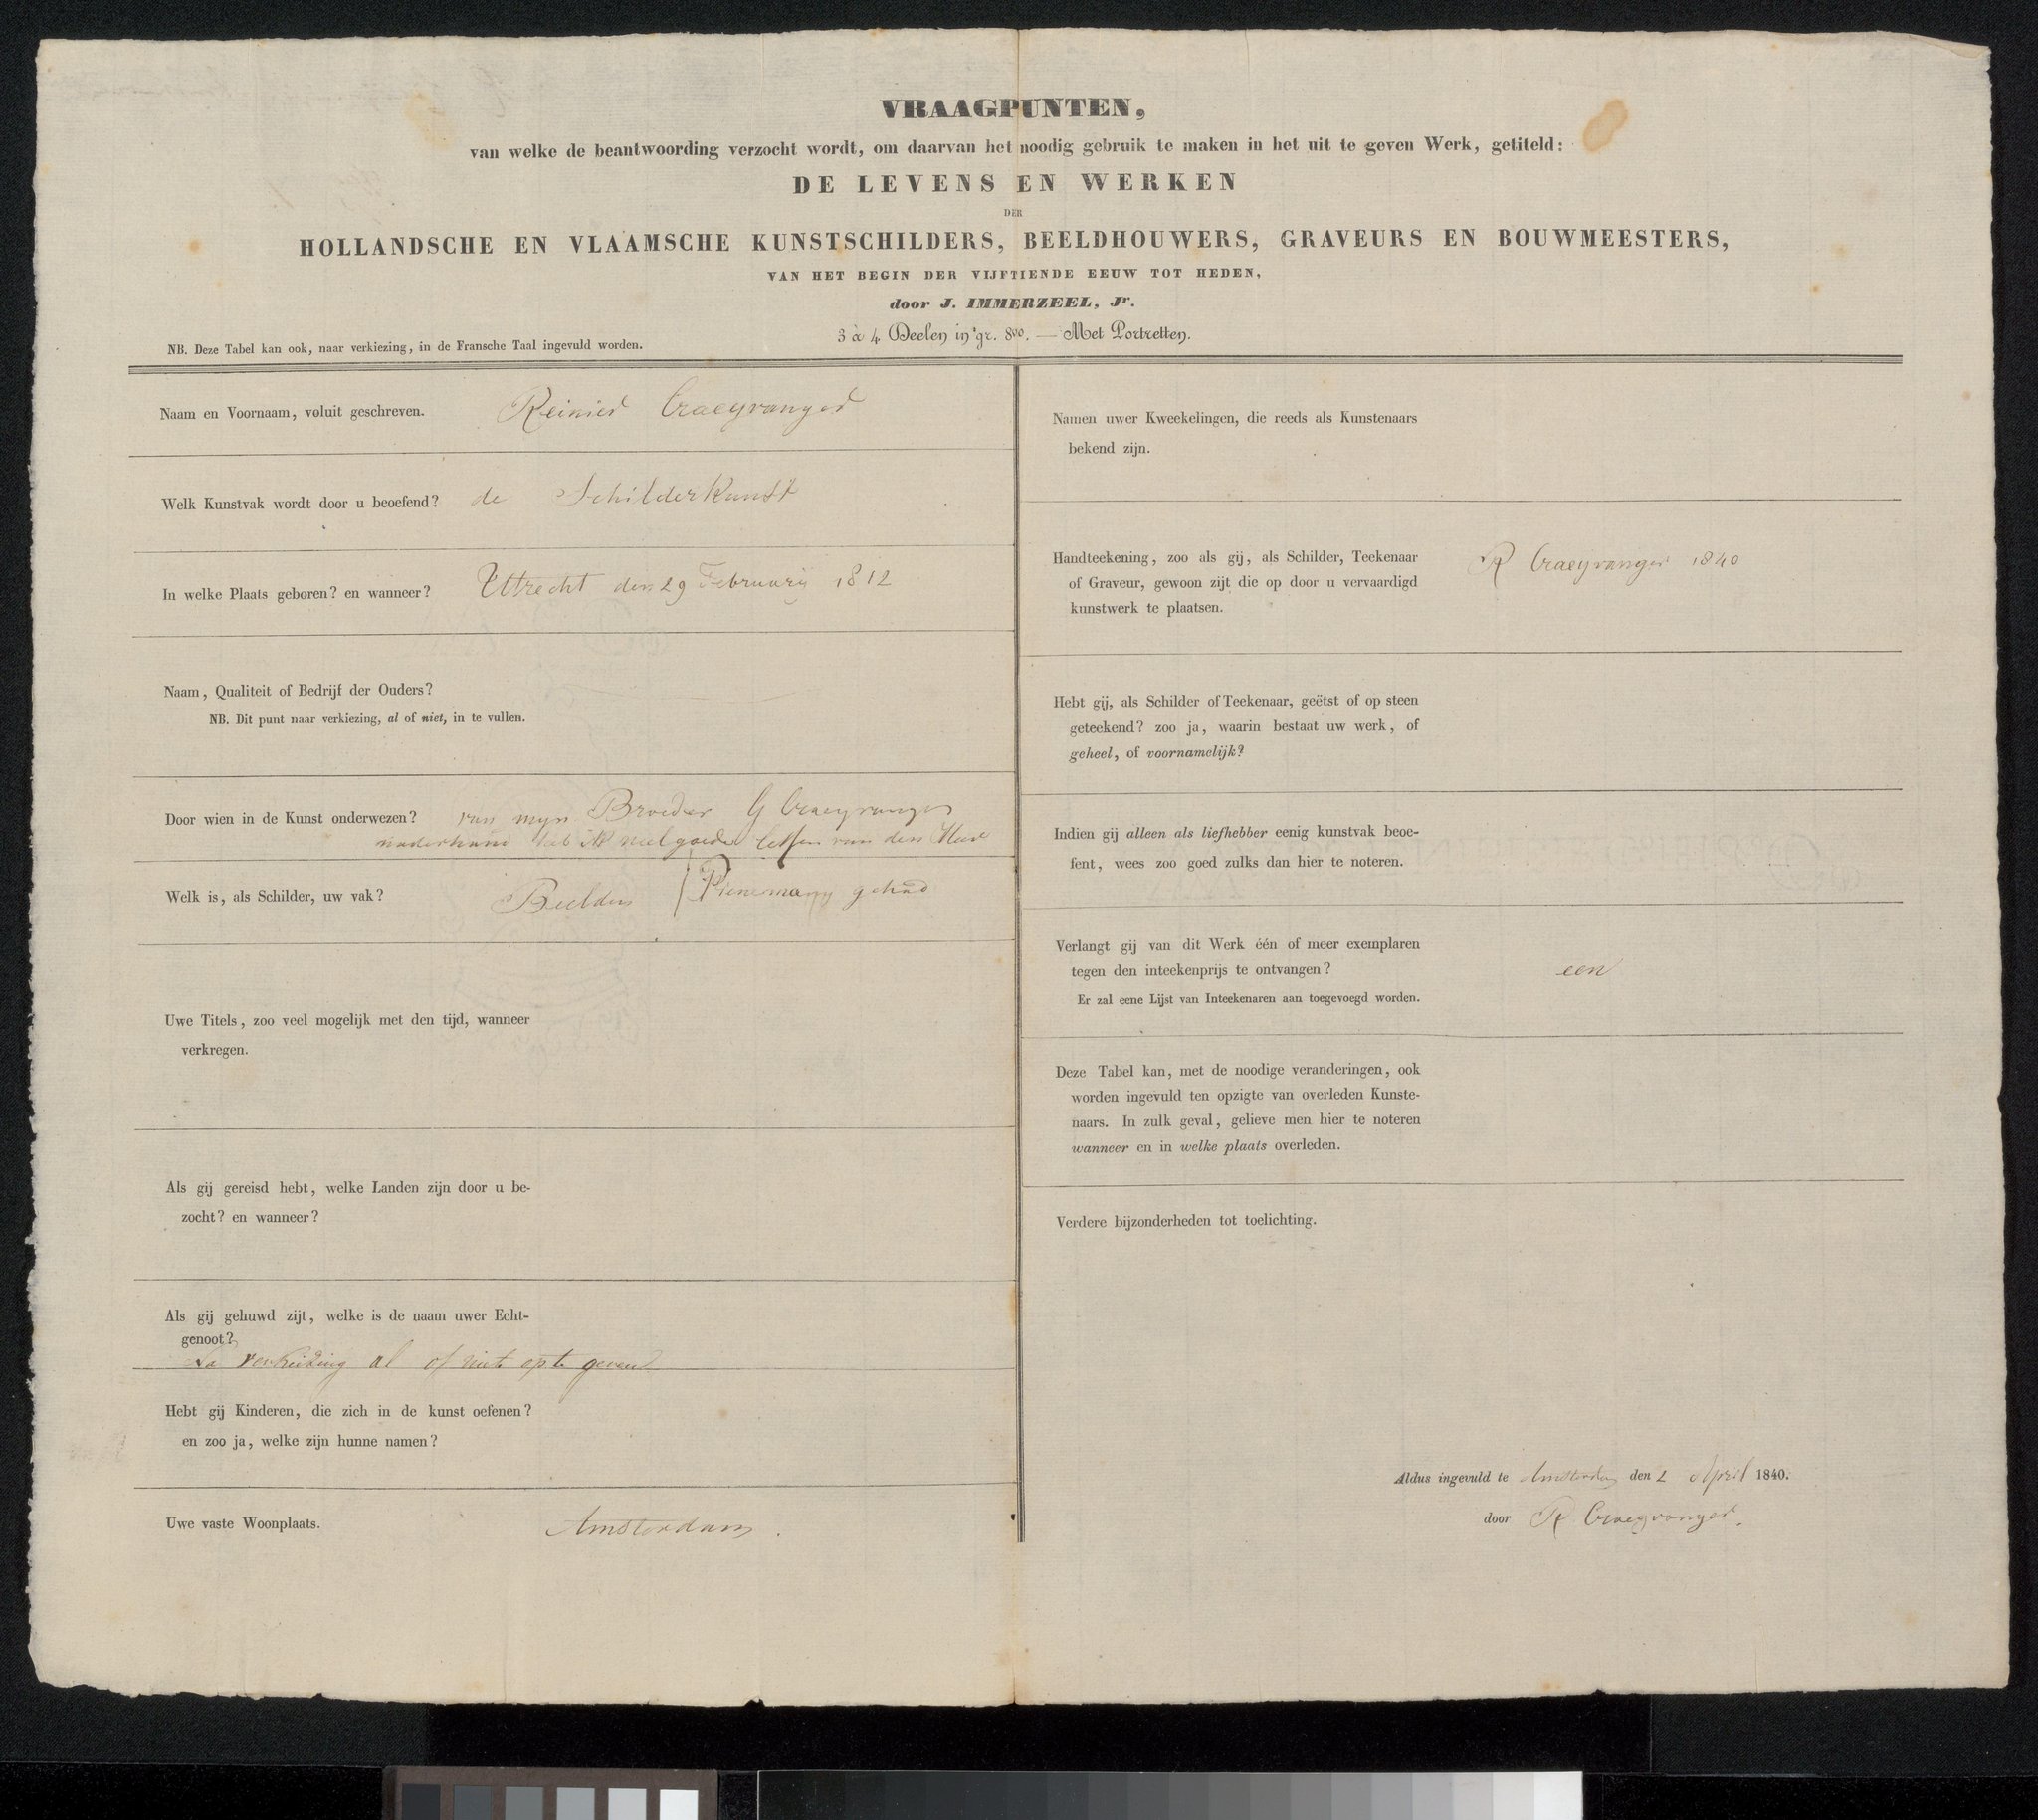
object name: questionnaire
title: Enquêteformulier ingevuld door Reinier Craeyvanger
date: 1840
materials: ink, paper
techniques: pen, printing, writing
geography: amsterdam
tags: utrecht, amsterdam, print maker, draughtsman, reinier craeyvanger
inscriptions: inscription: ‘Vraagpunten,/ van welke de beantwoording verzocht wordt, om daarvan het noodig gebruik te maken in het uit te geven Werk, getiteld: De levens en werken/ der Hollandsche en Vlaamsche kunstschilders, beeldhouwers,/ graveurs en bouwmeesters, van het begin der vijftiende eeuw tot heden/ door J. Immerzeel, Jr.’, watermark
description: Opgenomen in: Immerzeel, J. Jr., De levens en werken der Hollandsche en Vlaamsche kunstschilders, beeldhouwers, graveurs en bouwmeesters, van het begin der vijftiende eeuw tot heden, Amsterdam: J.C. van Kesteren, 1842-1843.